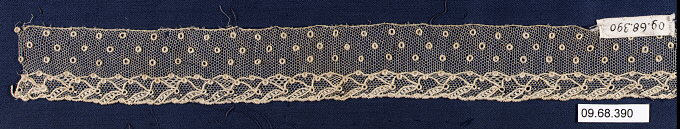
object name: fragment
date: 1801-1900